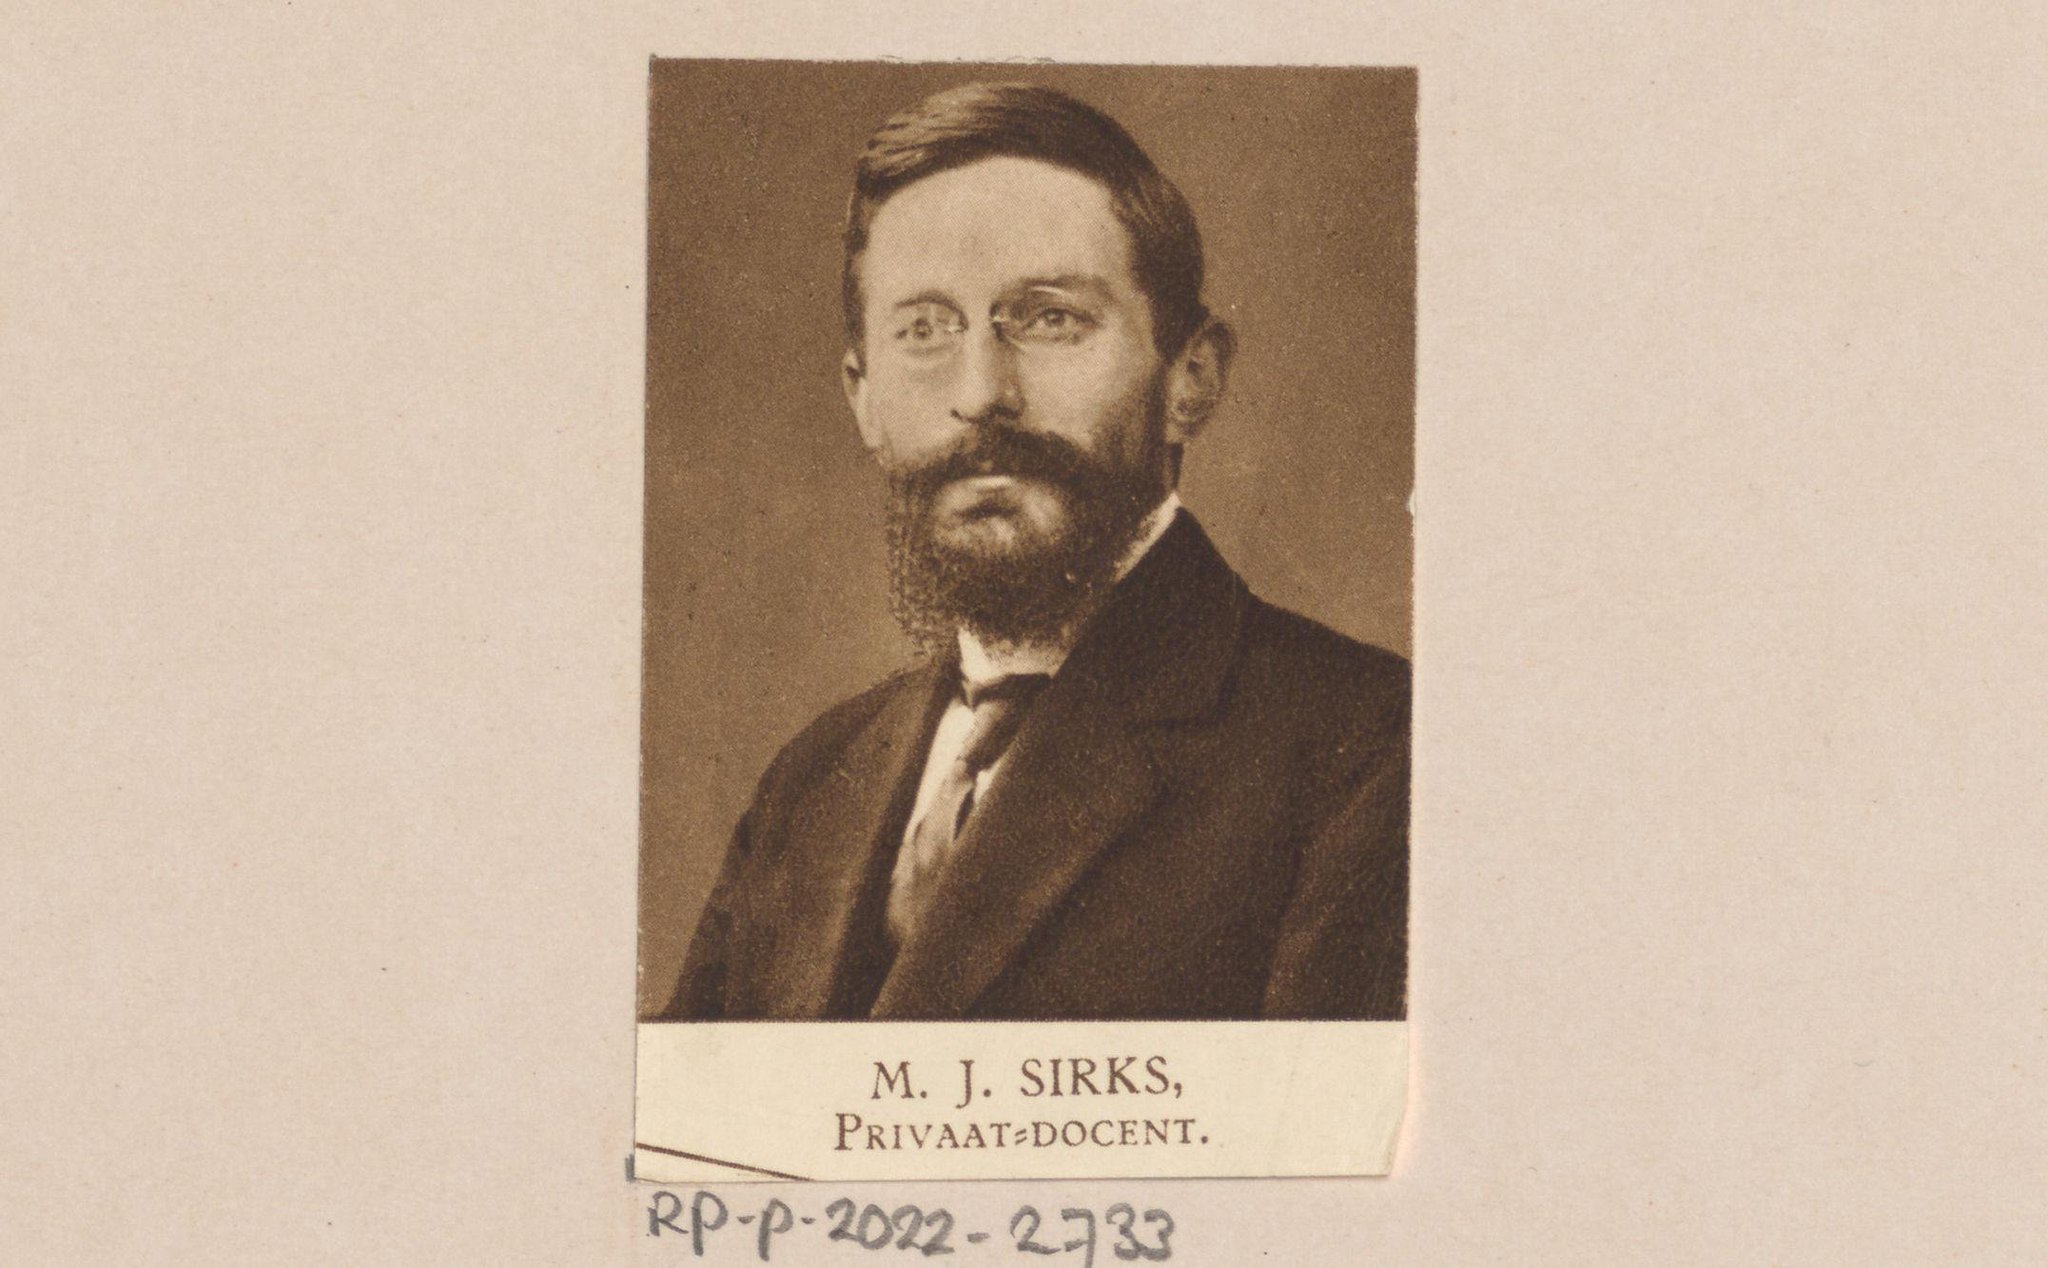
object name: photomechanical print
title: Portret van Marius Jacob Sirks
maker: Anonymous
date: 1929-1975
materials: paper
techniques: rotogravure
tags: botany (+ portrait of scholar, scientist), historical persons, professor